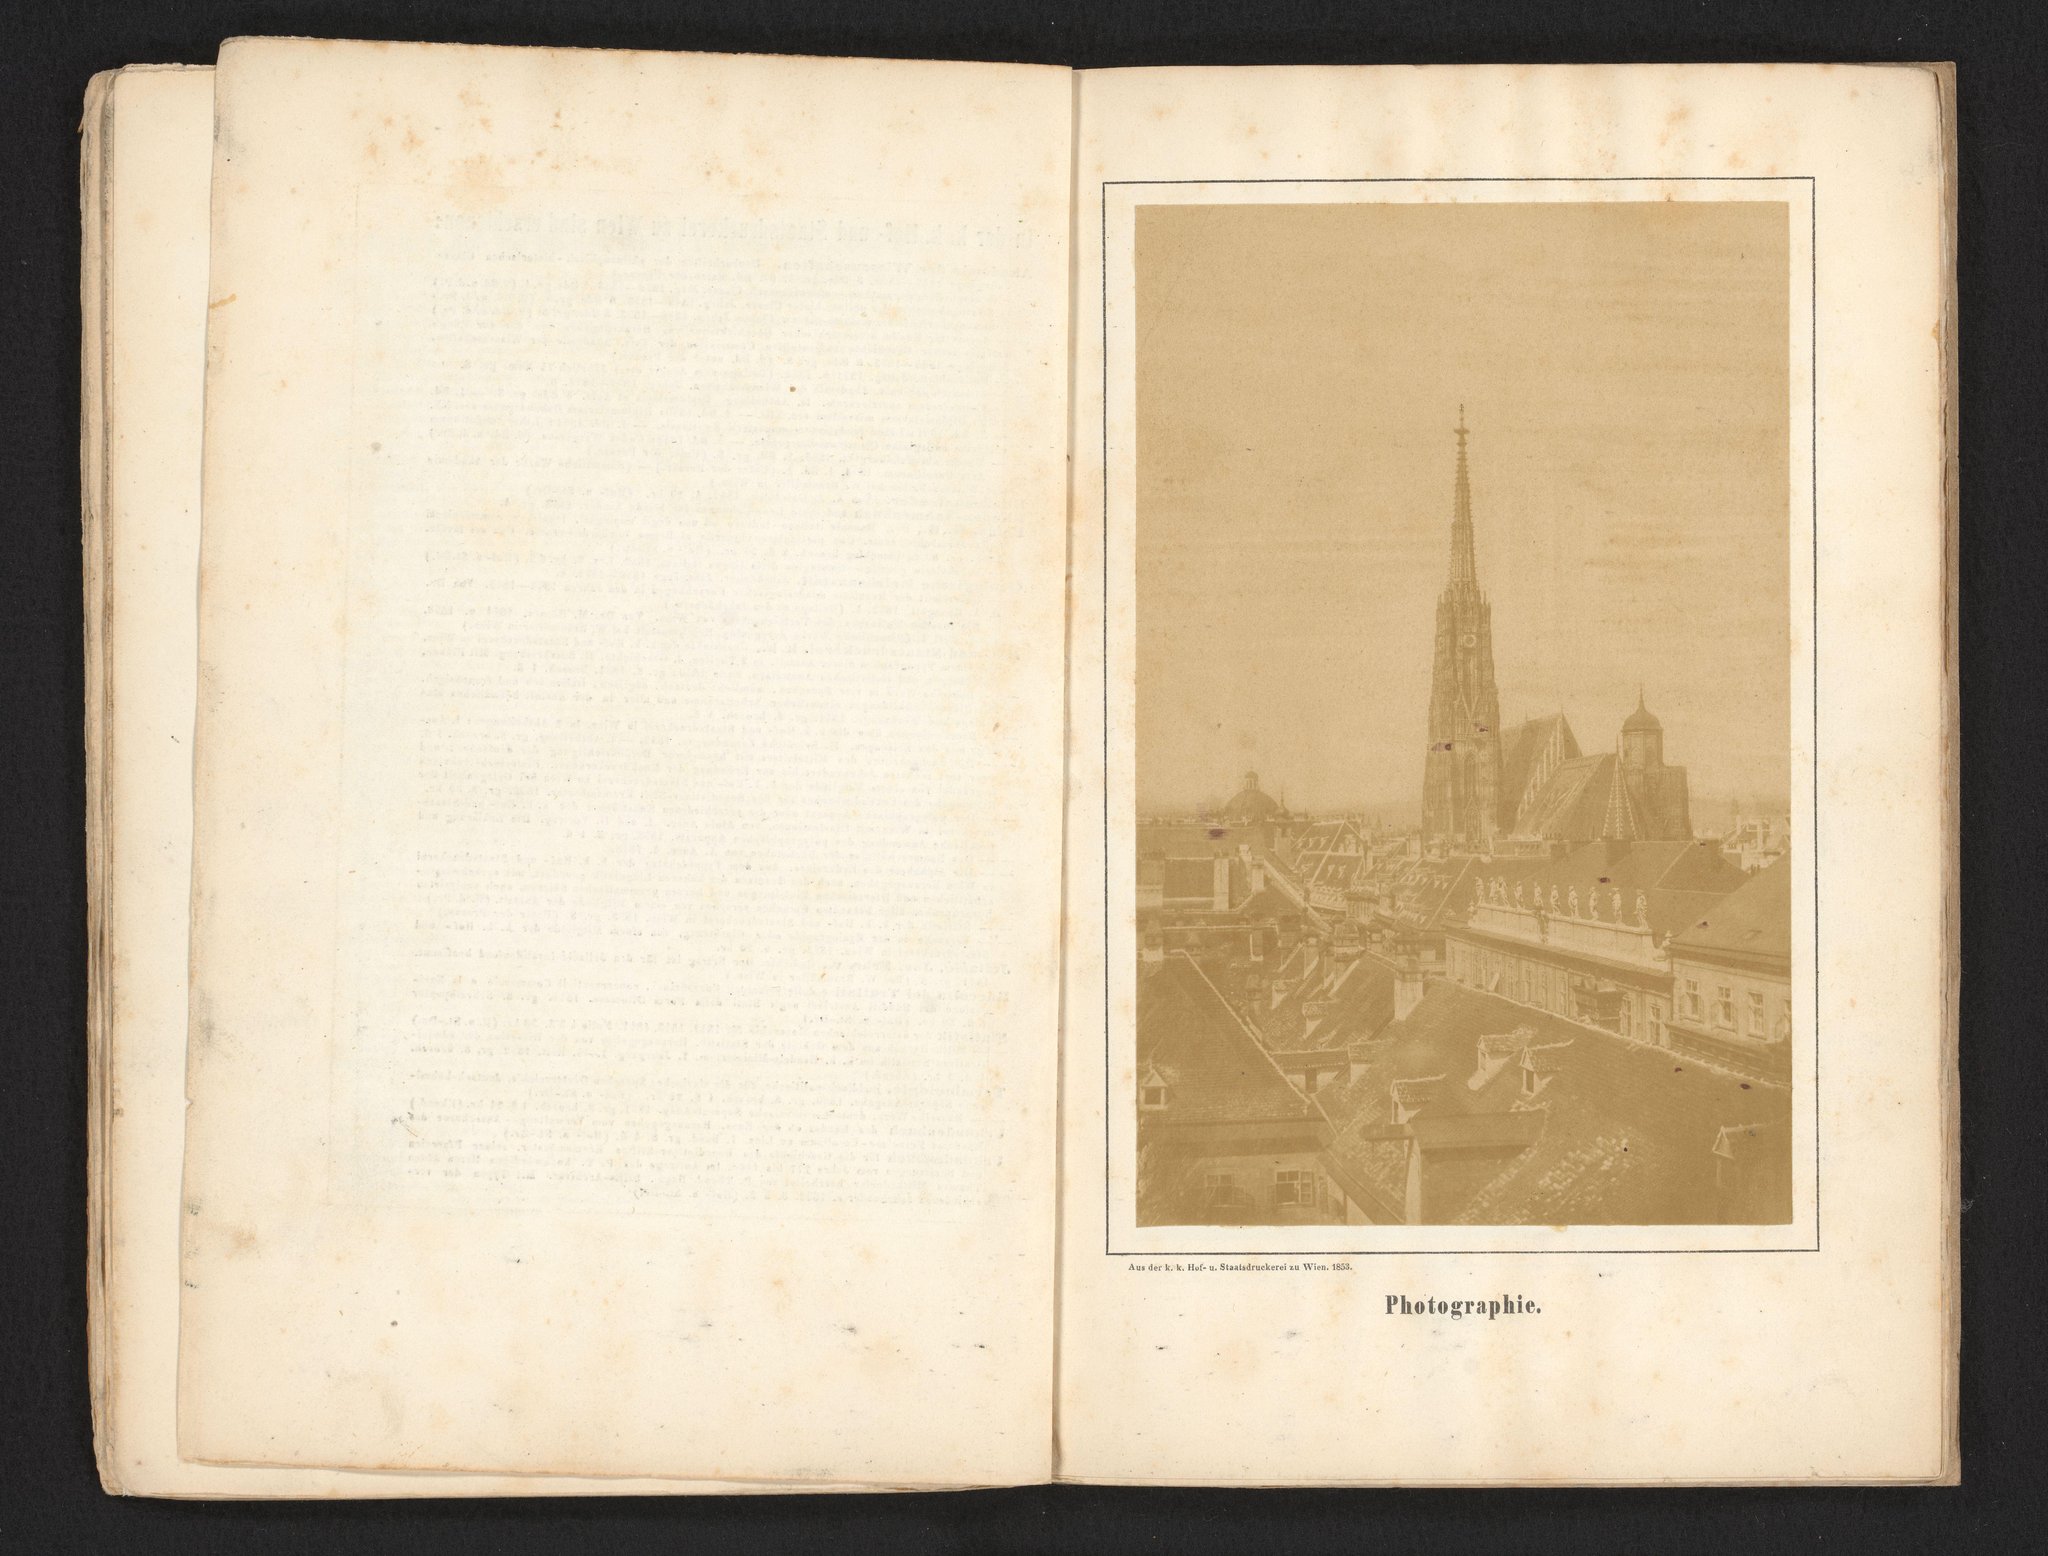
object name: photograph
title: Gezicht op de Stephansdom te Wenen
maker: Anonymous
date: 1853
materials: photographic support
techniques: albumen print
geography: vienna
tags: church (exterior), façade (of house or building)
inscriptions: inscription: ‘Aus der k.k. Hof- u. Staatsdruckerei zu Wien. 1853.’